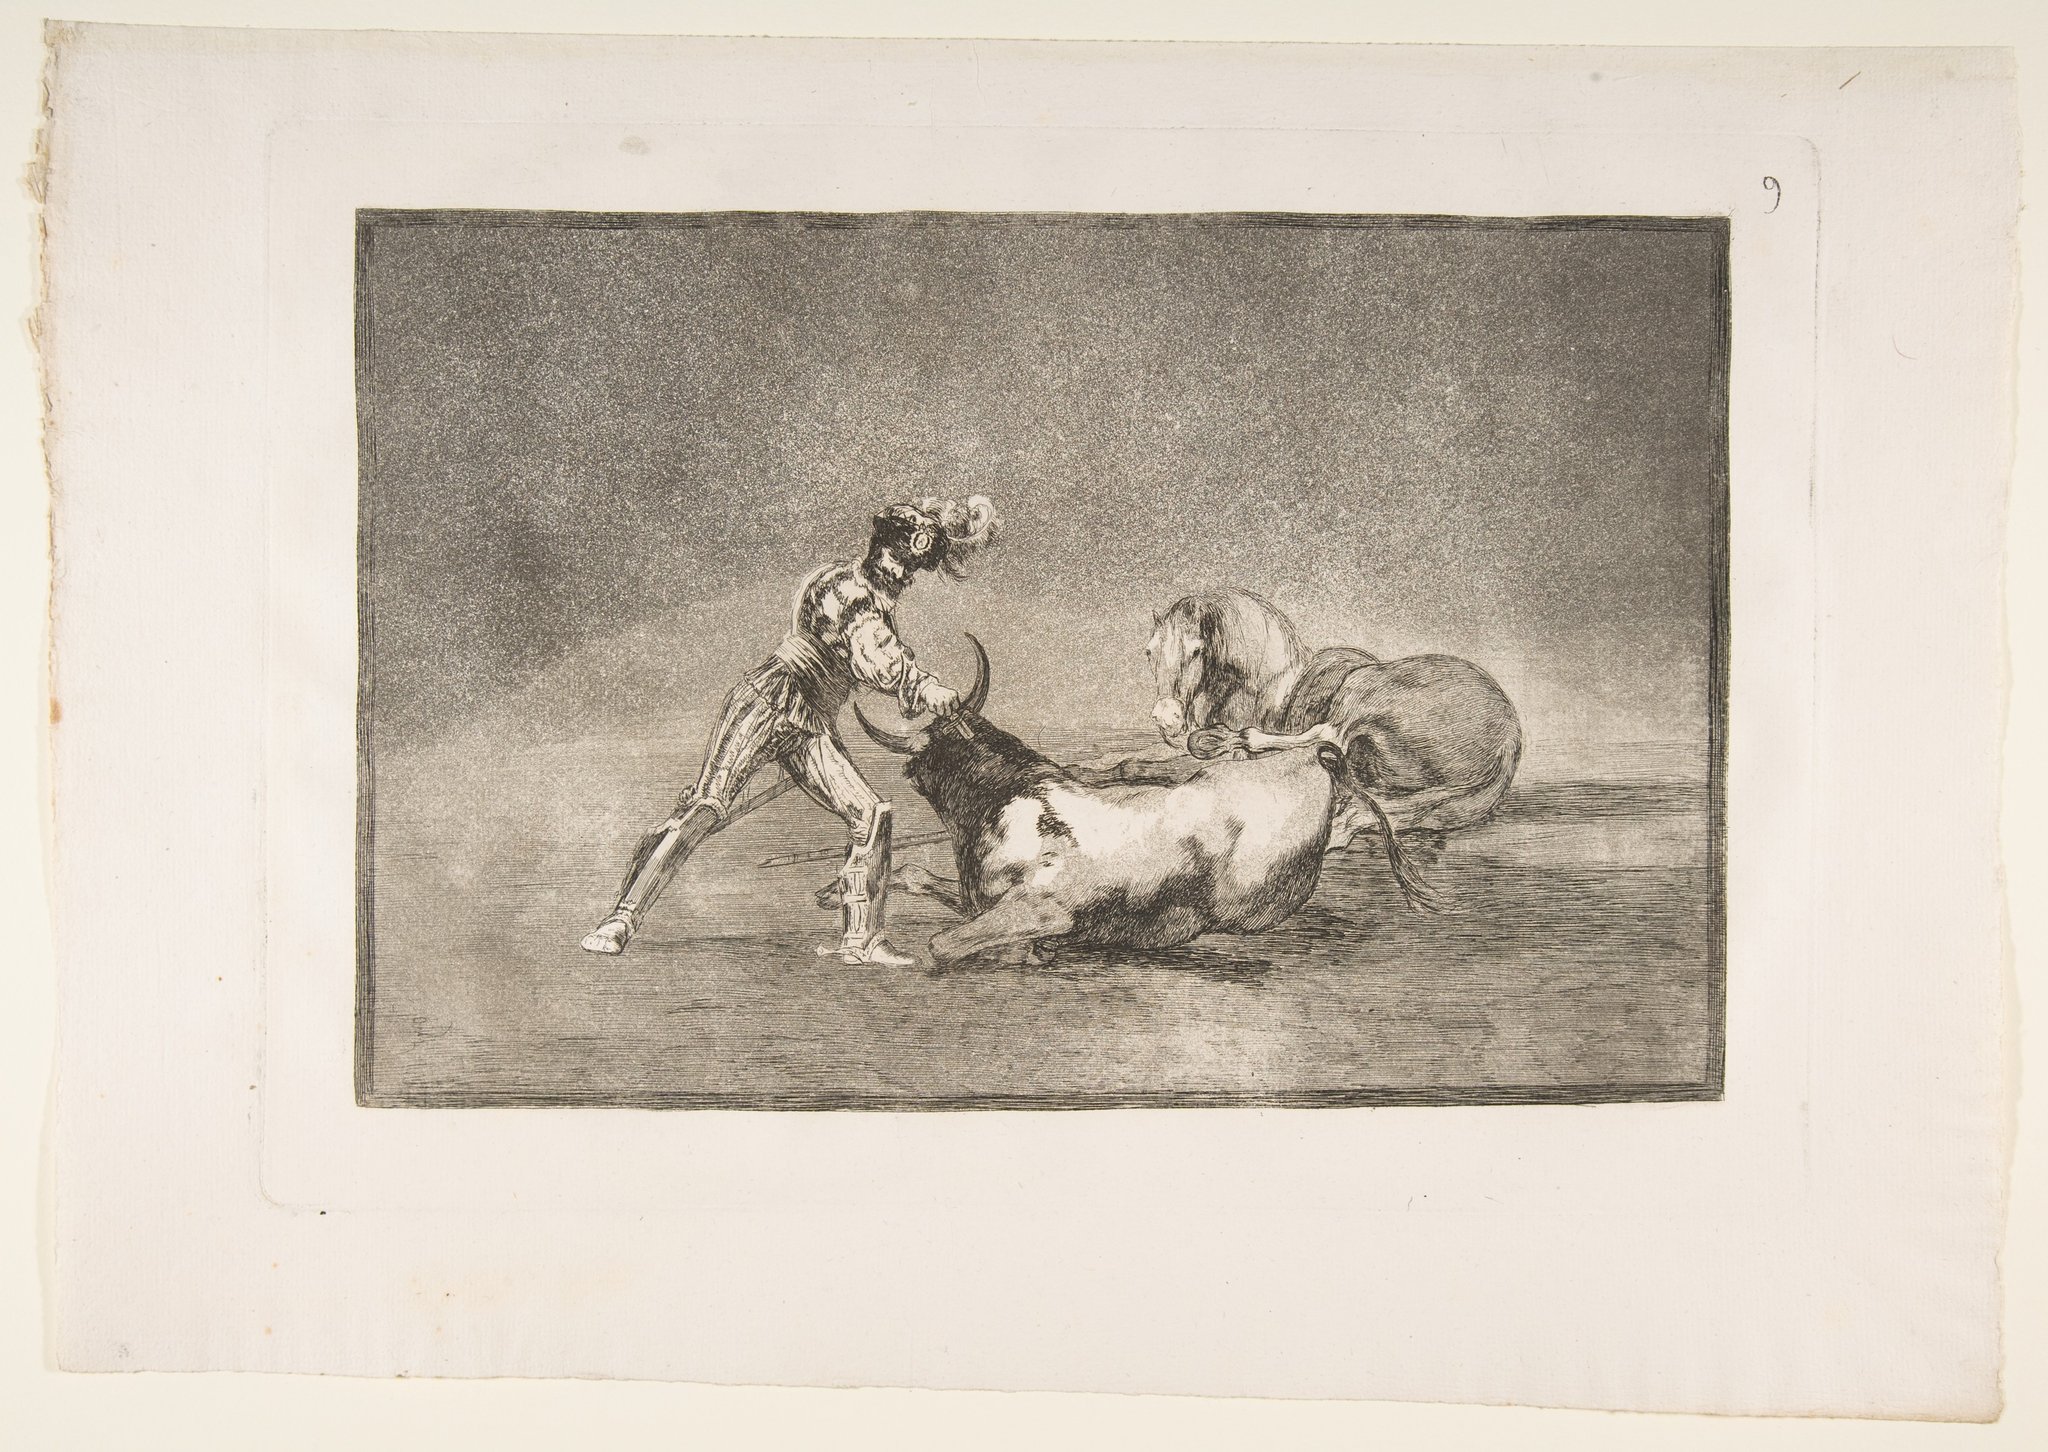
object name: print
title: Plate 9 from "La Tauromaquia": A Spanish knight kills the bull after having lost his horse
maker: goya (francisco de goya y lucientes)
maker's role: artist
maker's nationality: spanish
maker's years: 1746-1828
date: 1816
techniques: aquatint, engraving, burnishing, etching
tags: men,bulls,horses,knights